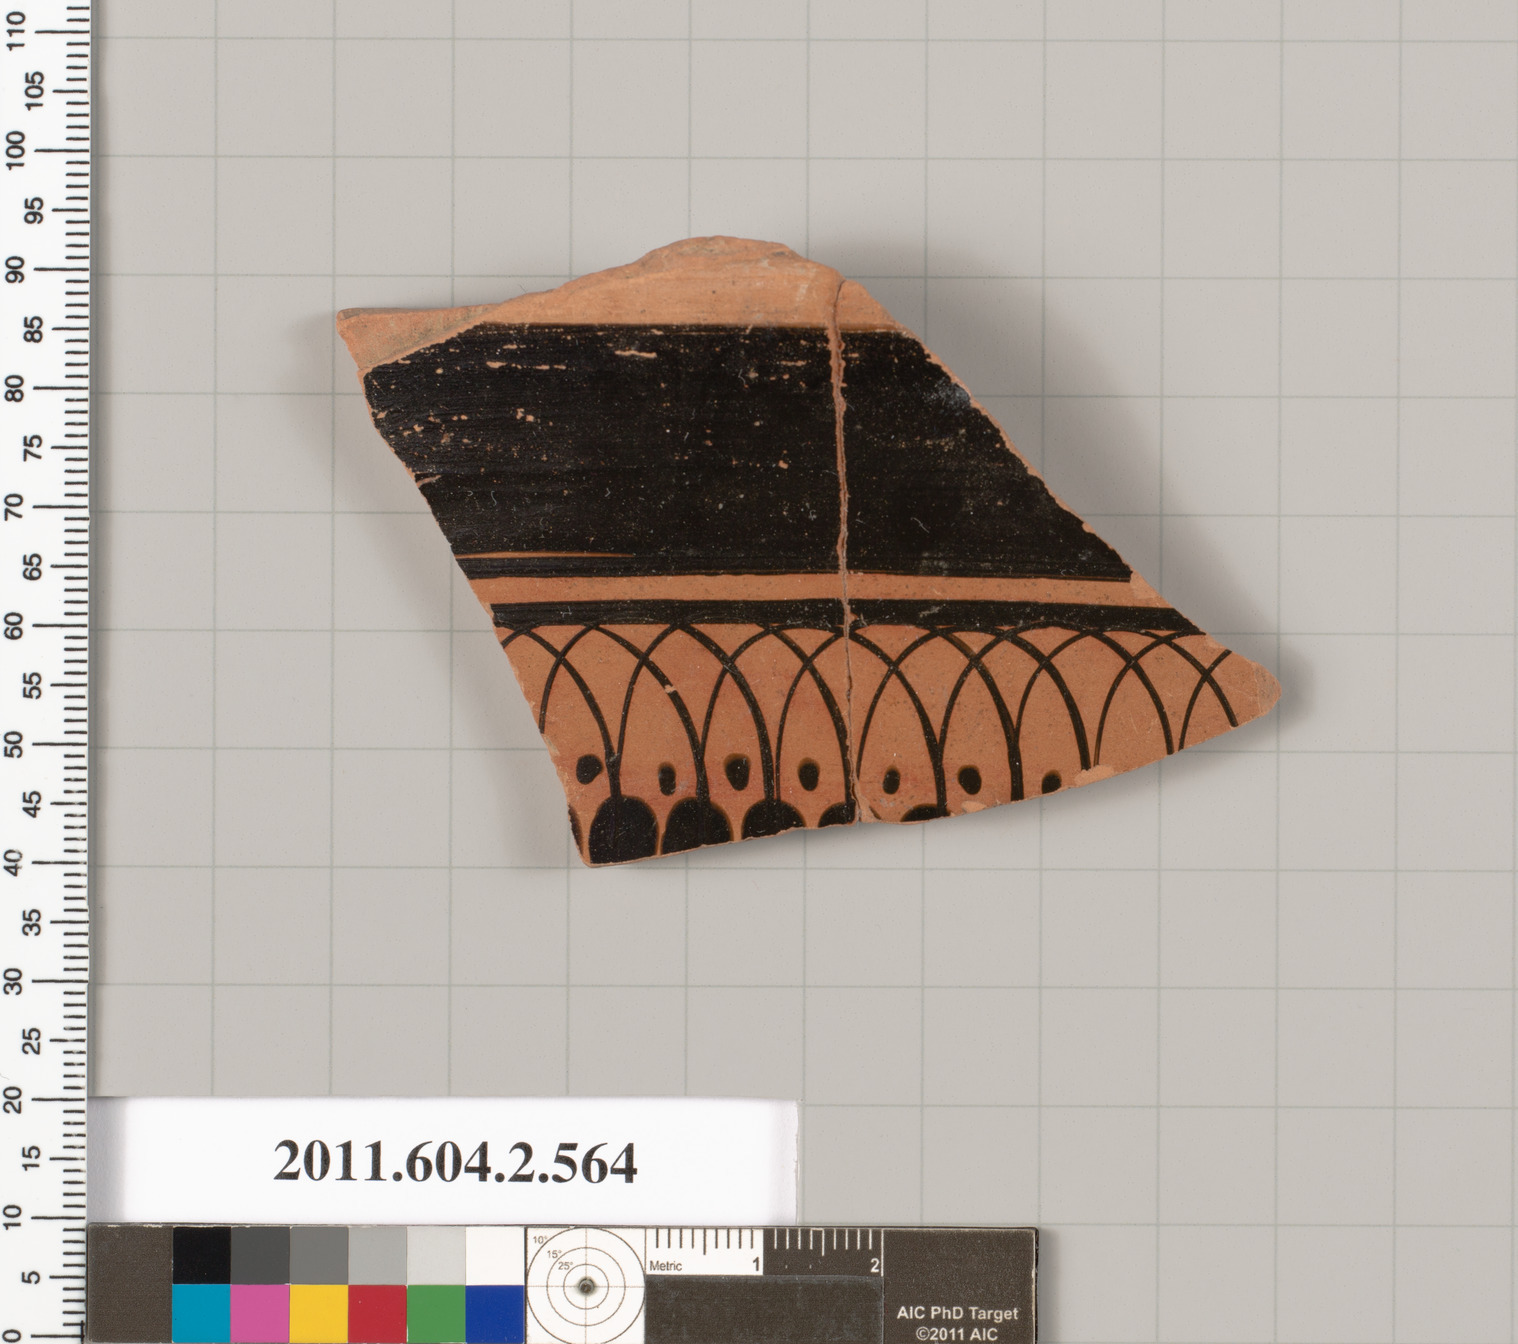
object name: column krater fragment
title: Terracotta fragment of a column-krater (bowl for mixing wine and water)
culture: greek, attic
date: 460-440 BCE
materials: terracotta